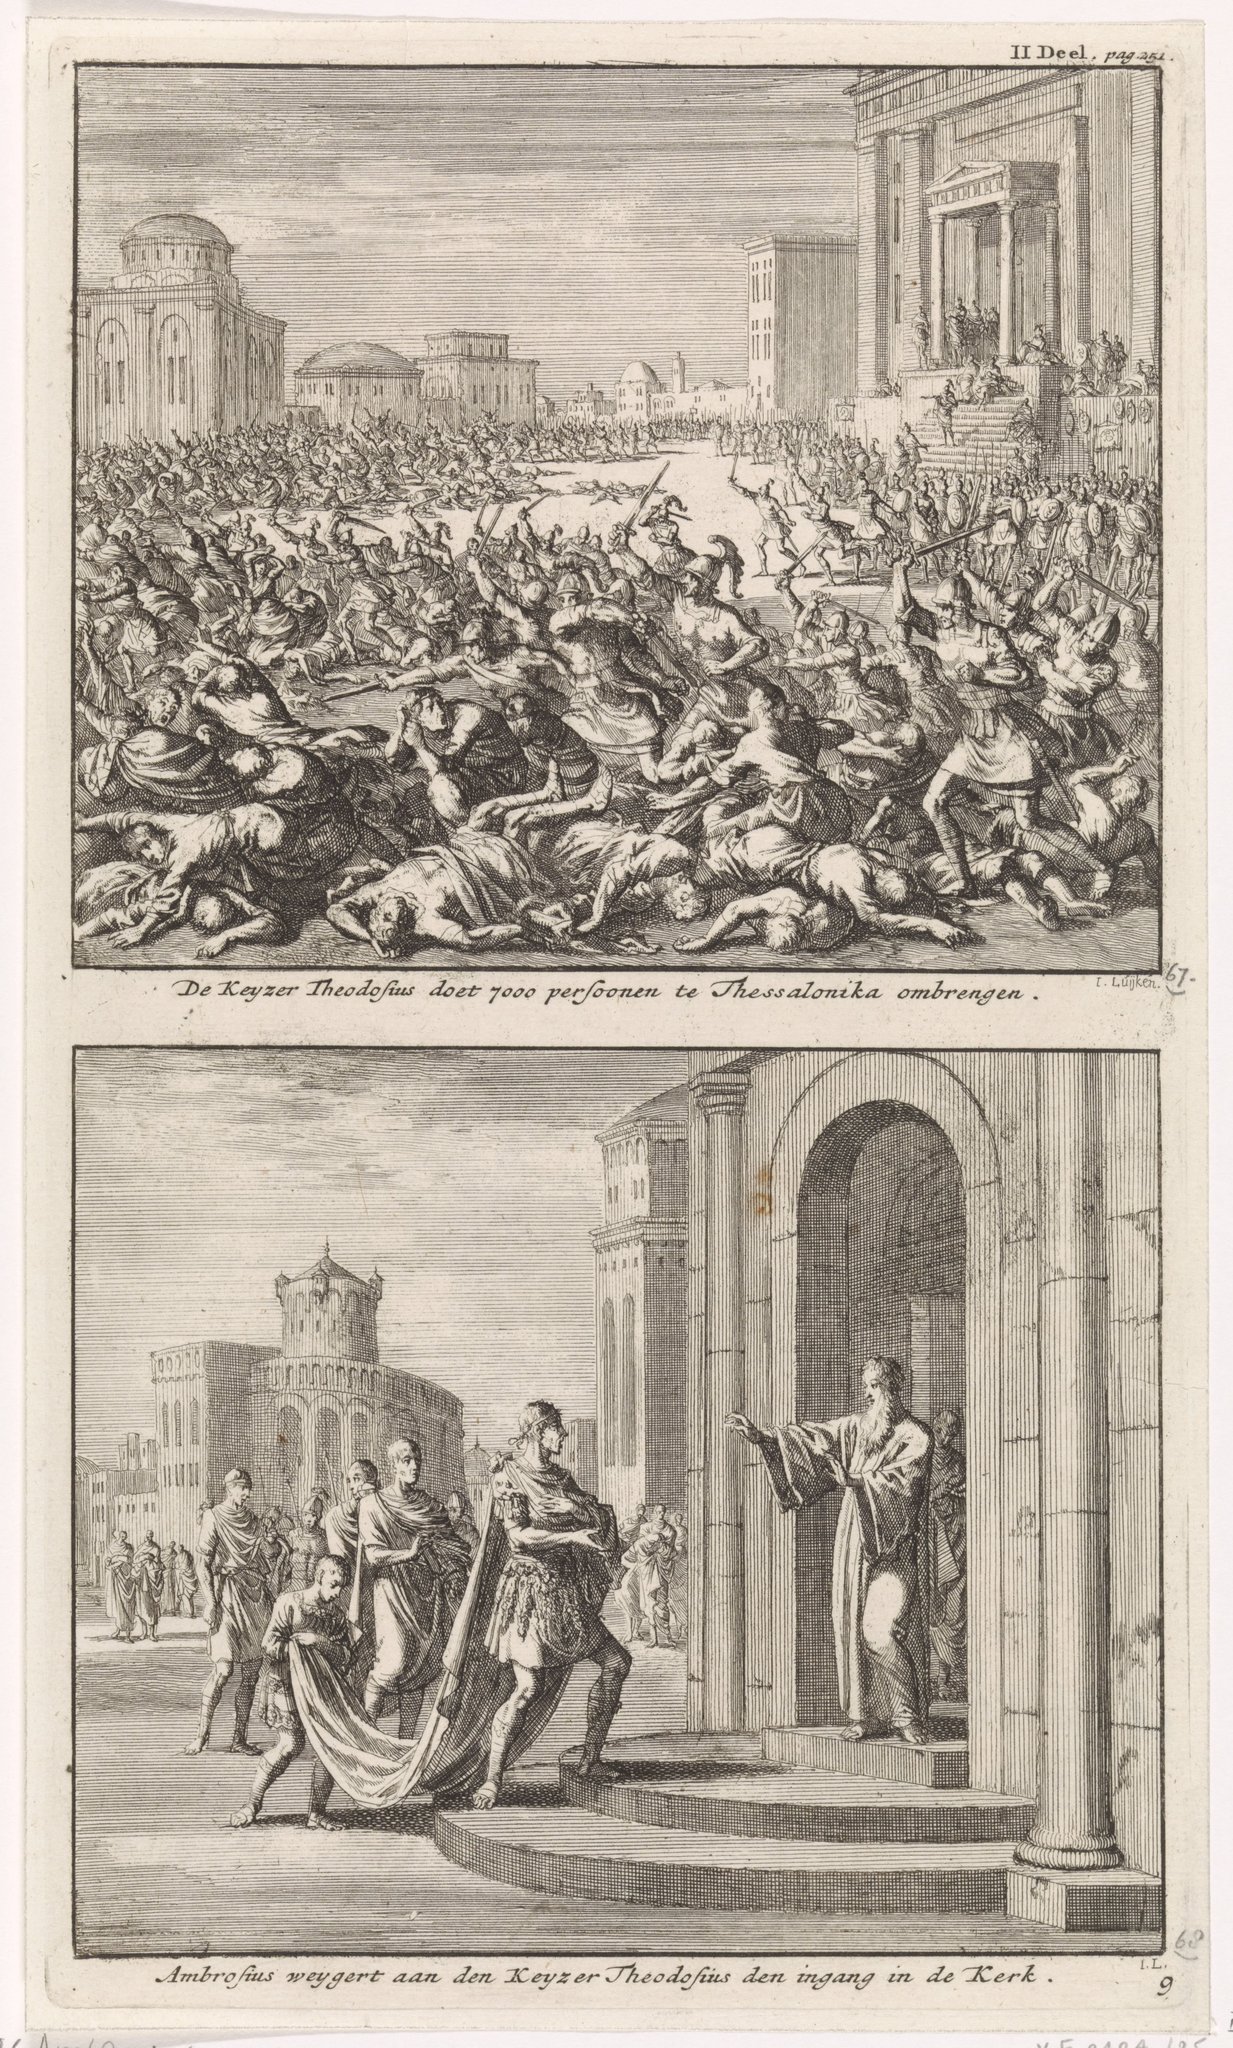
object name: print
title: De Keyzer Theodosius doet 7000 persoonen te Thessalonika ombrengen / Ambrosius weygert aan den Keyzer Theodosius den ingang in de Kerk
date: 1701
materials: paper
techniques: etching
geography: amsterdam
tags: violent death by sword, the early christian churches, e.g. armenians, copts, syrians, st. ambrose refuses emperor theodosius admission to the church, massacre ~ war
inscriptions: collector's mark: Lugt 2228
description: Twee voorstellingen op een plaat. Boven: Op het centrale plein van Thessaloniki worden zevenduizend burgers afgeslacht door soldaten. Rechts op de achtergrond Keizer Theodosius I, die het bevel tot de slachting geeft. Onder: de H. Ambrosius staat in het portaal van een kathedraal met de handen uitgestoken. Tegenover hem staat keizer Theodosius I. Ambrodius verbiedt hem de kerk te betreden omdat Theodosius zevenduizend burgers van Thessaloniki heeft laten afslachten.